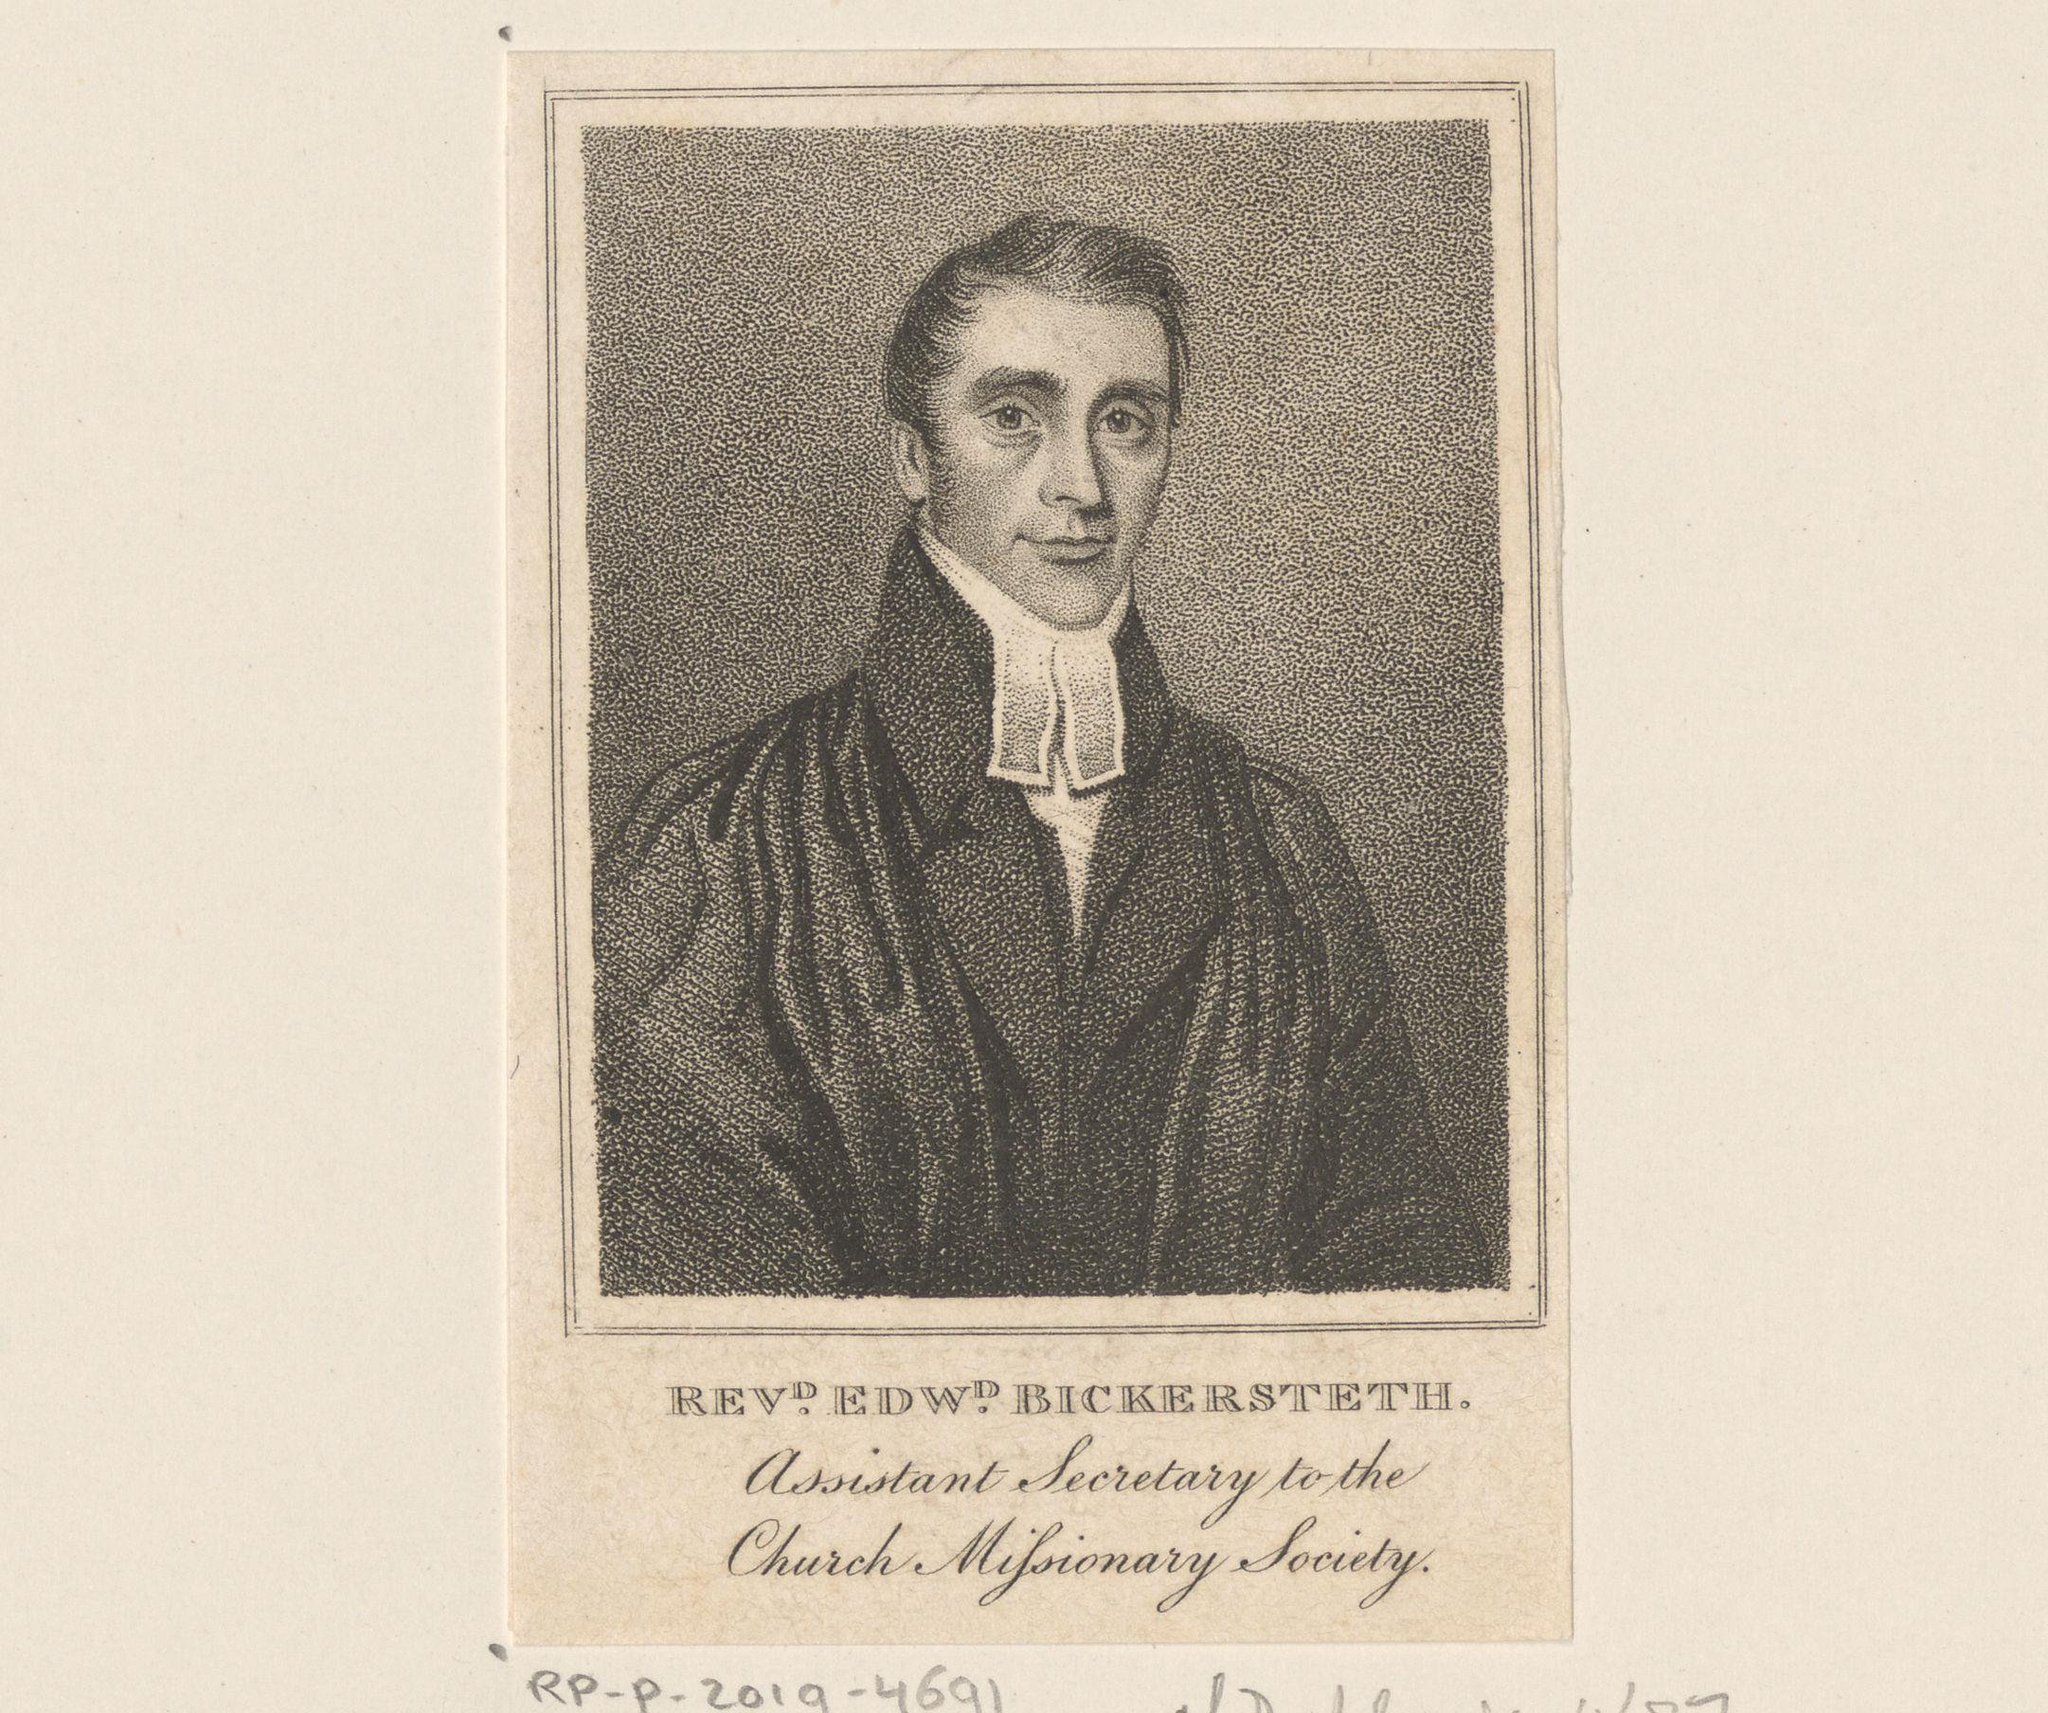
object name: print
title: Portret van Edward Bickersteth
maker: Anonymous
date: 1815-1849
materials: paper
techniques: etching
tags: historical persons